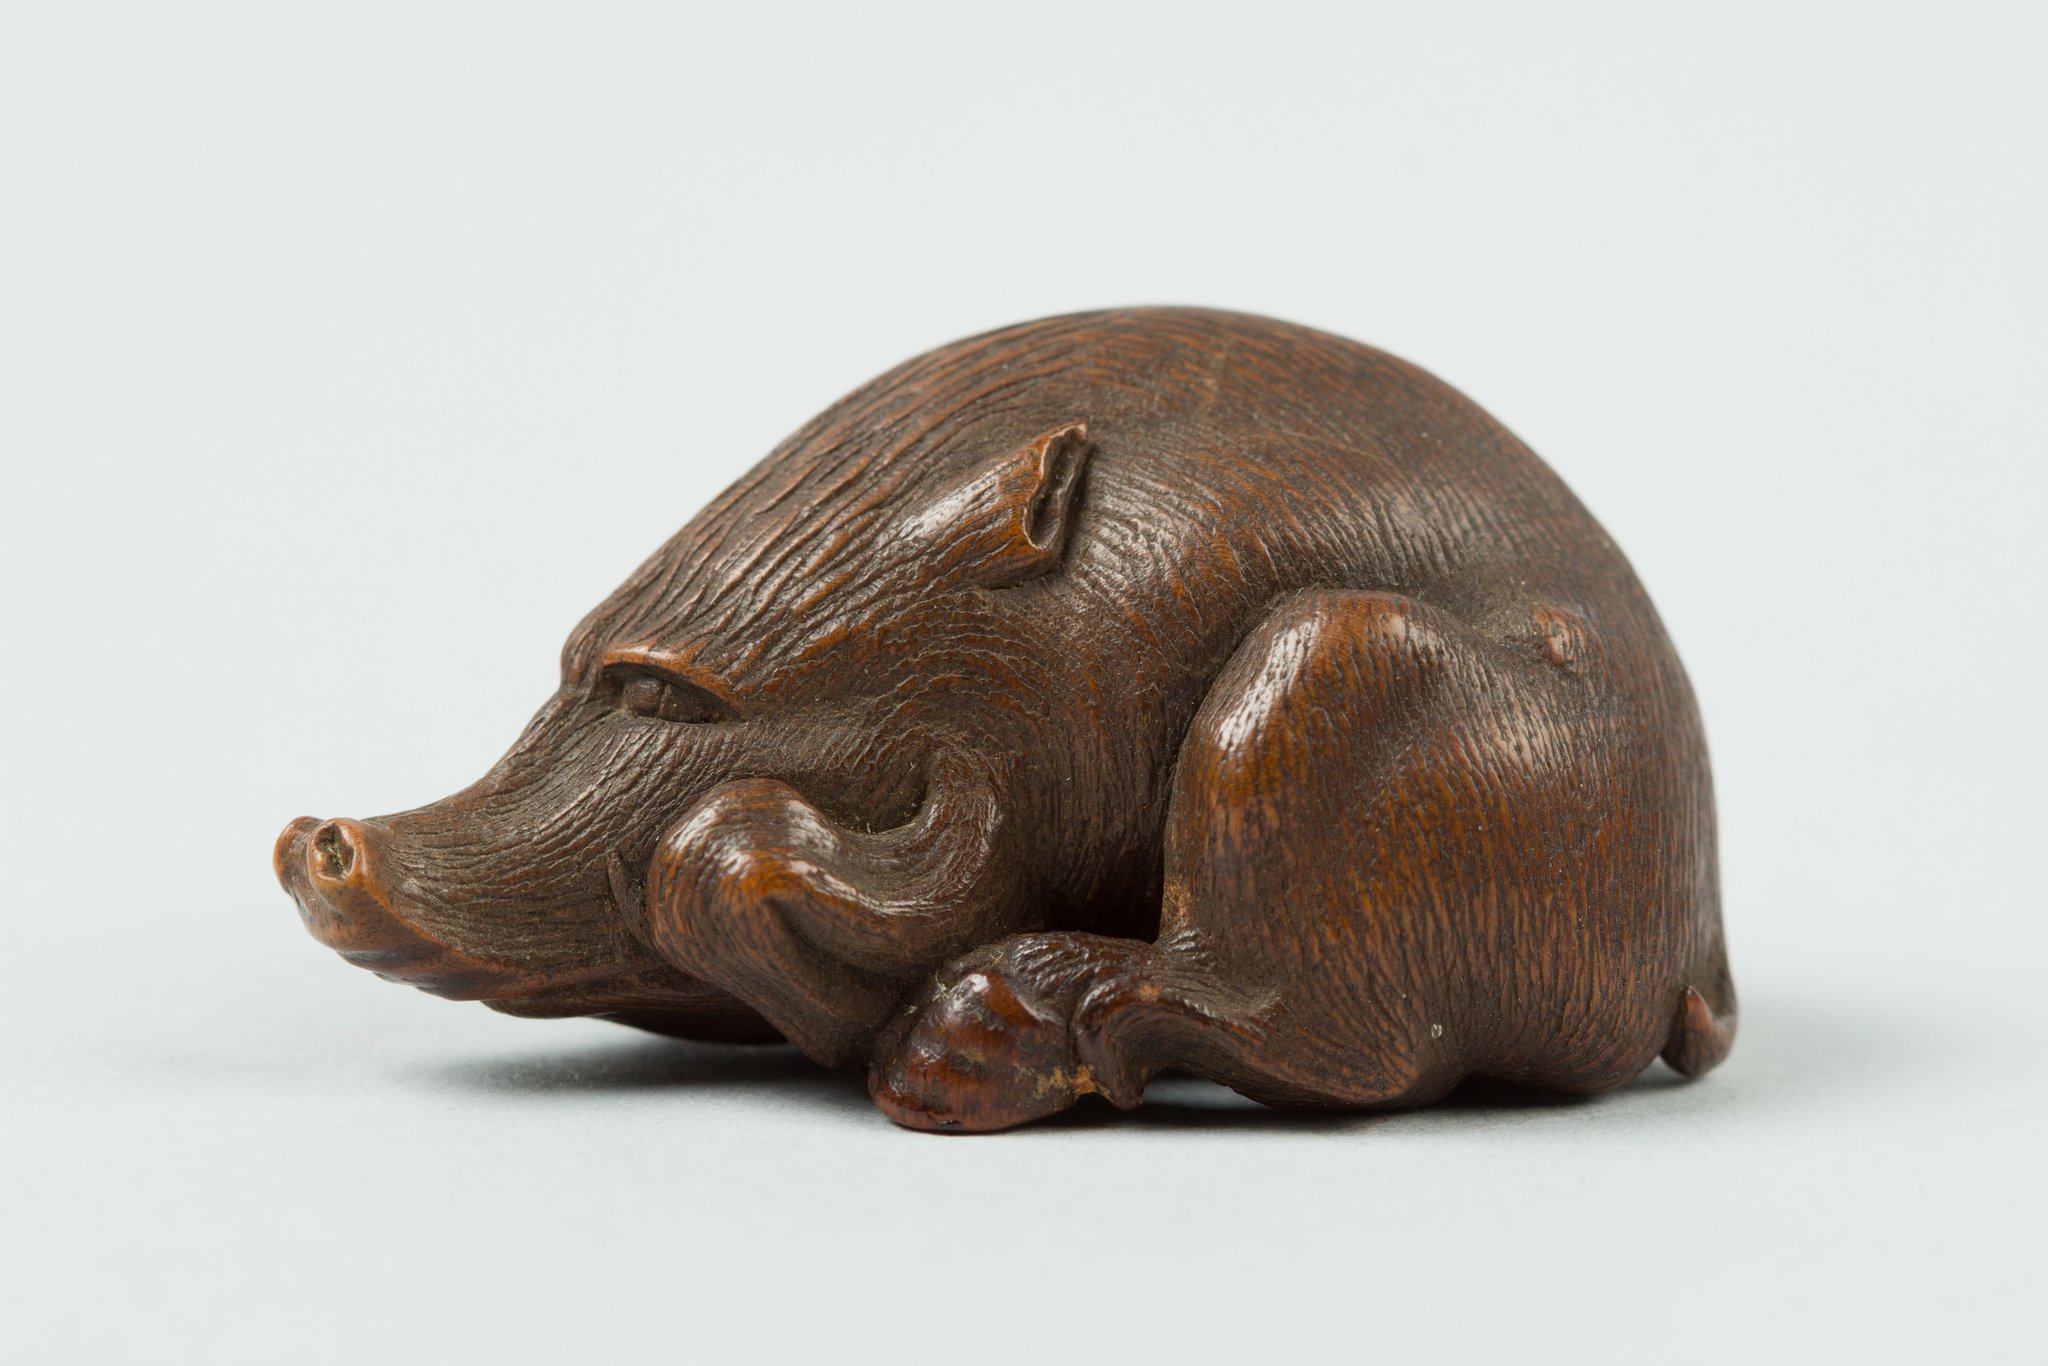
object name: netsuke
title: Netsuke of a Boar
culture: japanese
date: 1801-1900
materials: wood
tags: boars